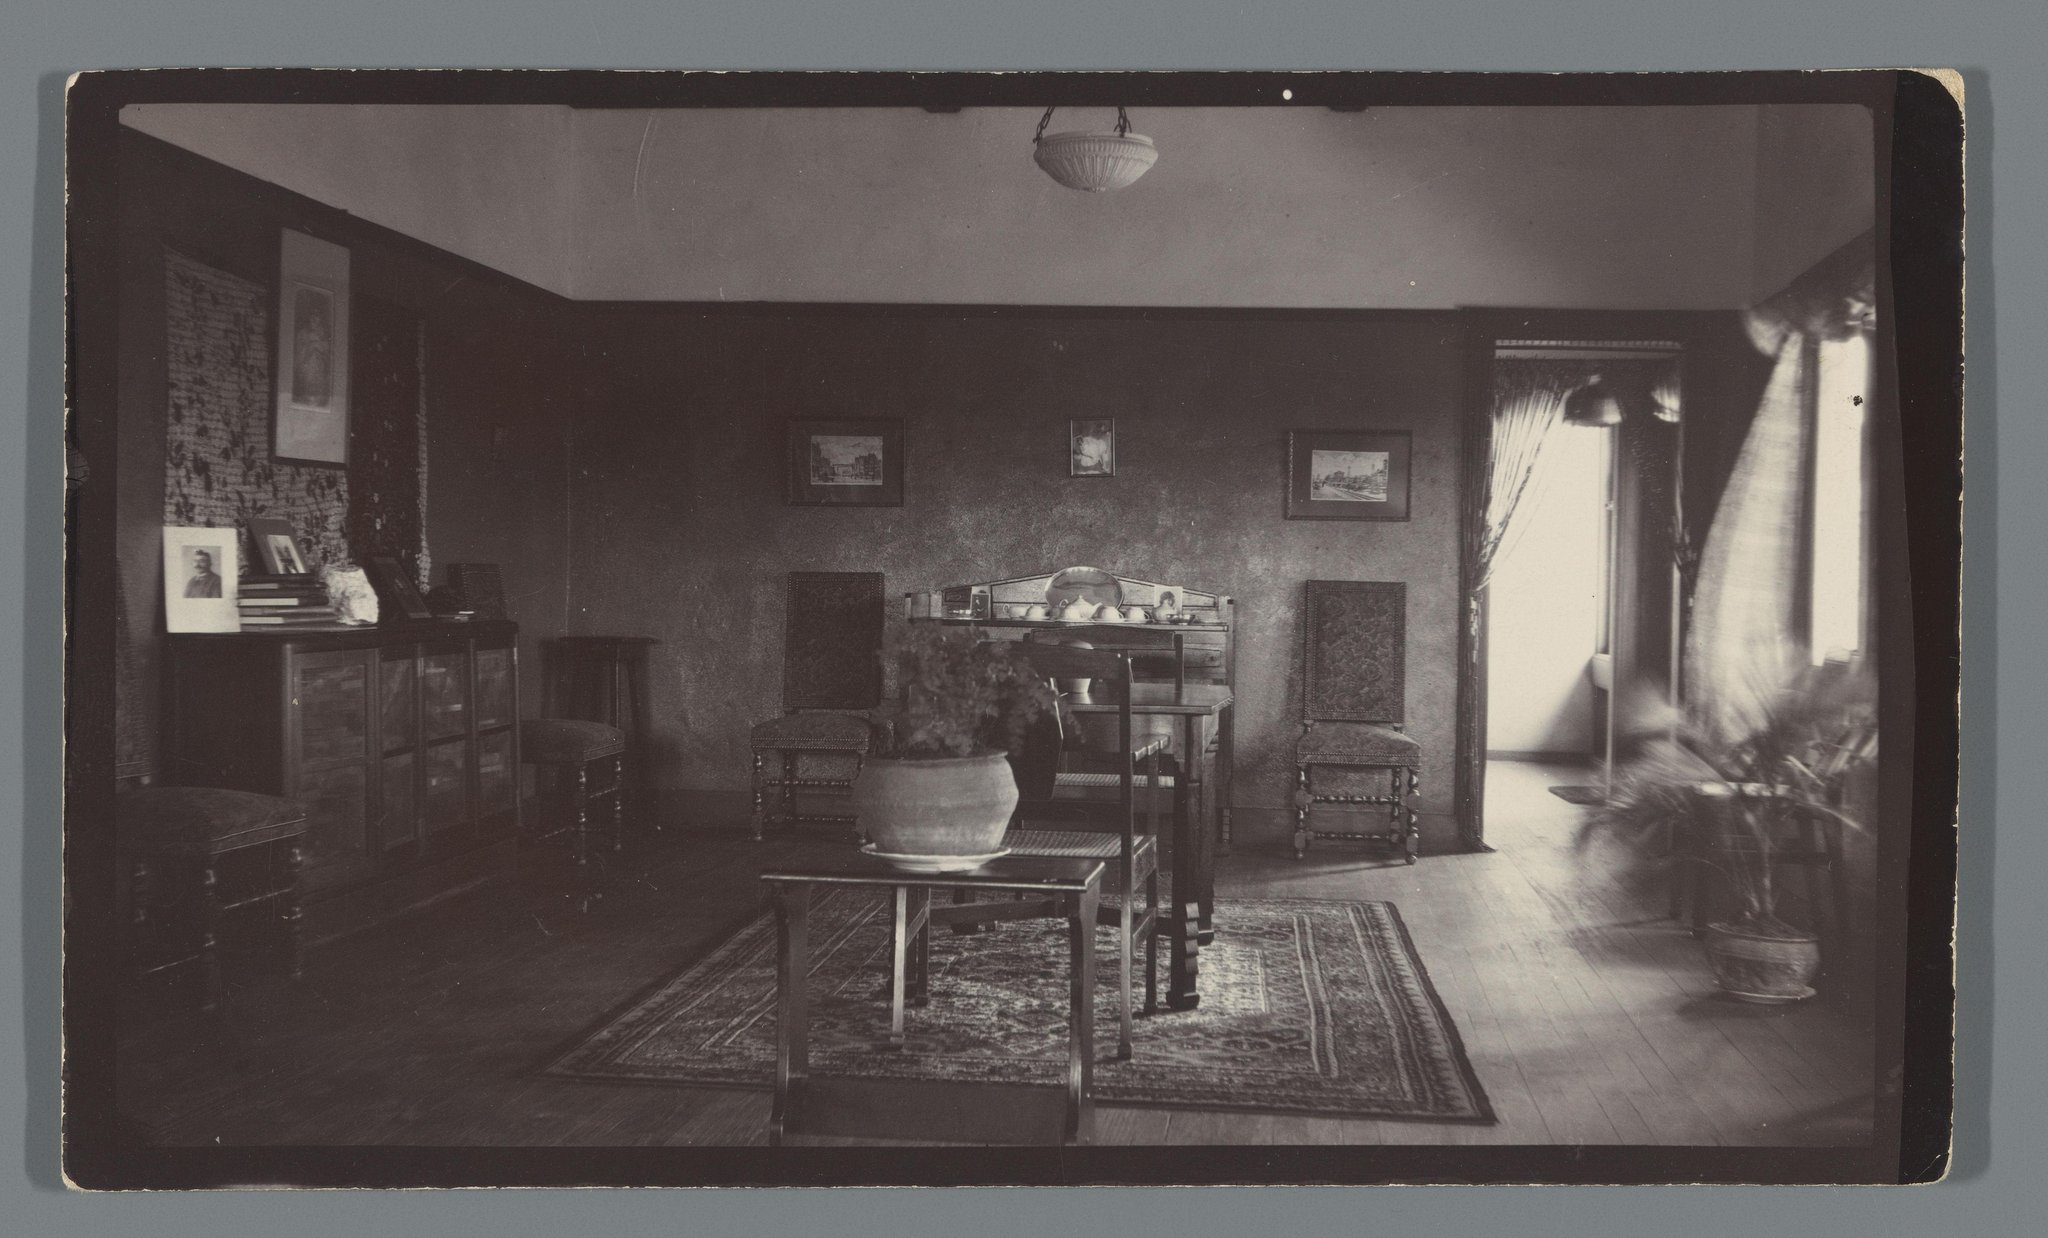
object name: photograph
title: Interieur van een huis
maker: Anonymous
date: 1925-1927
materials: photographic support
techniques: photography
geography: suriname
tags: jetten, familie, moengo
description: Interieur van een huis, waarschijnlijk het huis van het echtpaar Jetten. Onderdeel van het ensemble met foto's van de familie van ingenieur Jetten in de mijnbouwstad Moengo in Suriname.